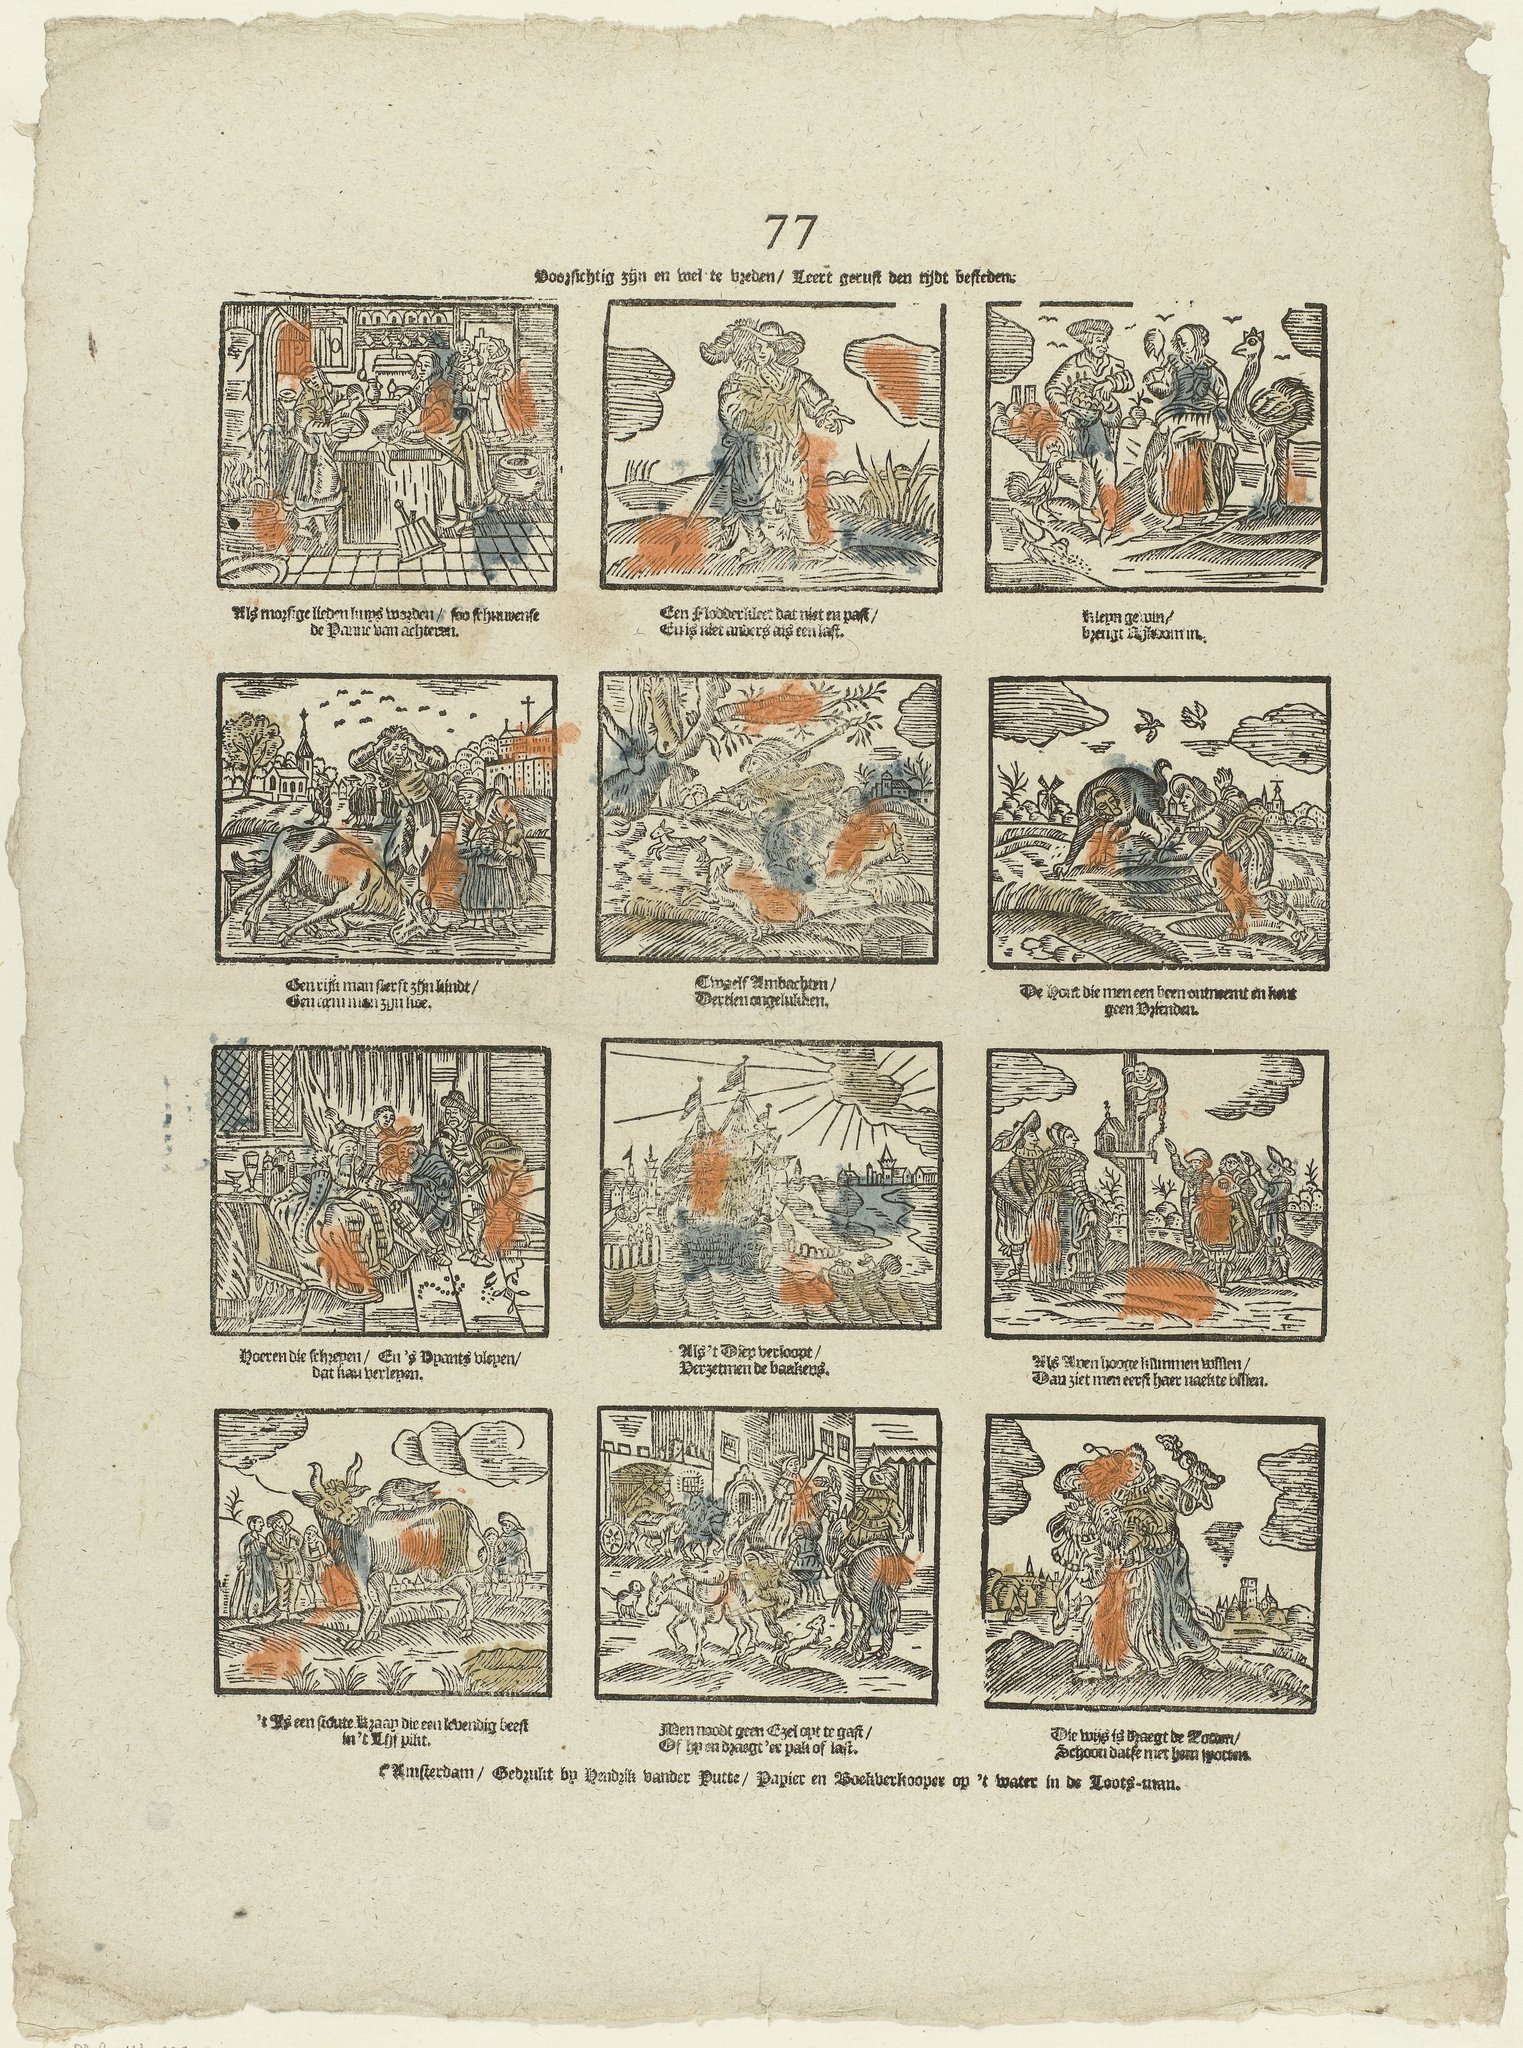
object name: popular print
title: Voorzichtig zijn en wel te vreden / Leert gerust den tijdt besteden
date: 1761-1765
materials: paper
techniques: colour, letterpress printing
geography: netherlands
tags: proverbs, sayings, etc.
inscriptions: collector's mark: Lugt 2760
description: Blad met 12 verbeeldingen van spreekwoorden. Onder elke afbeelding een tweeregelig vers. Genummerd midden boven: 77.